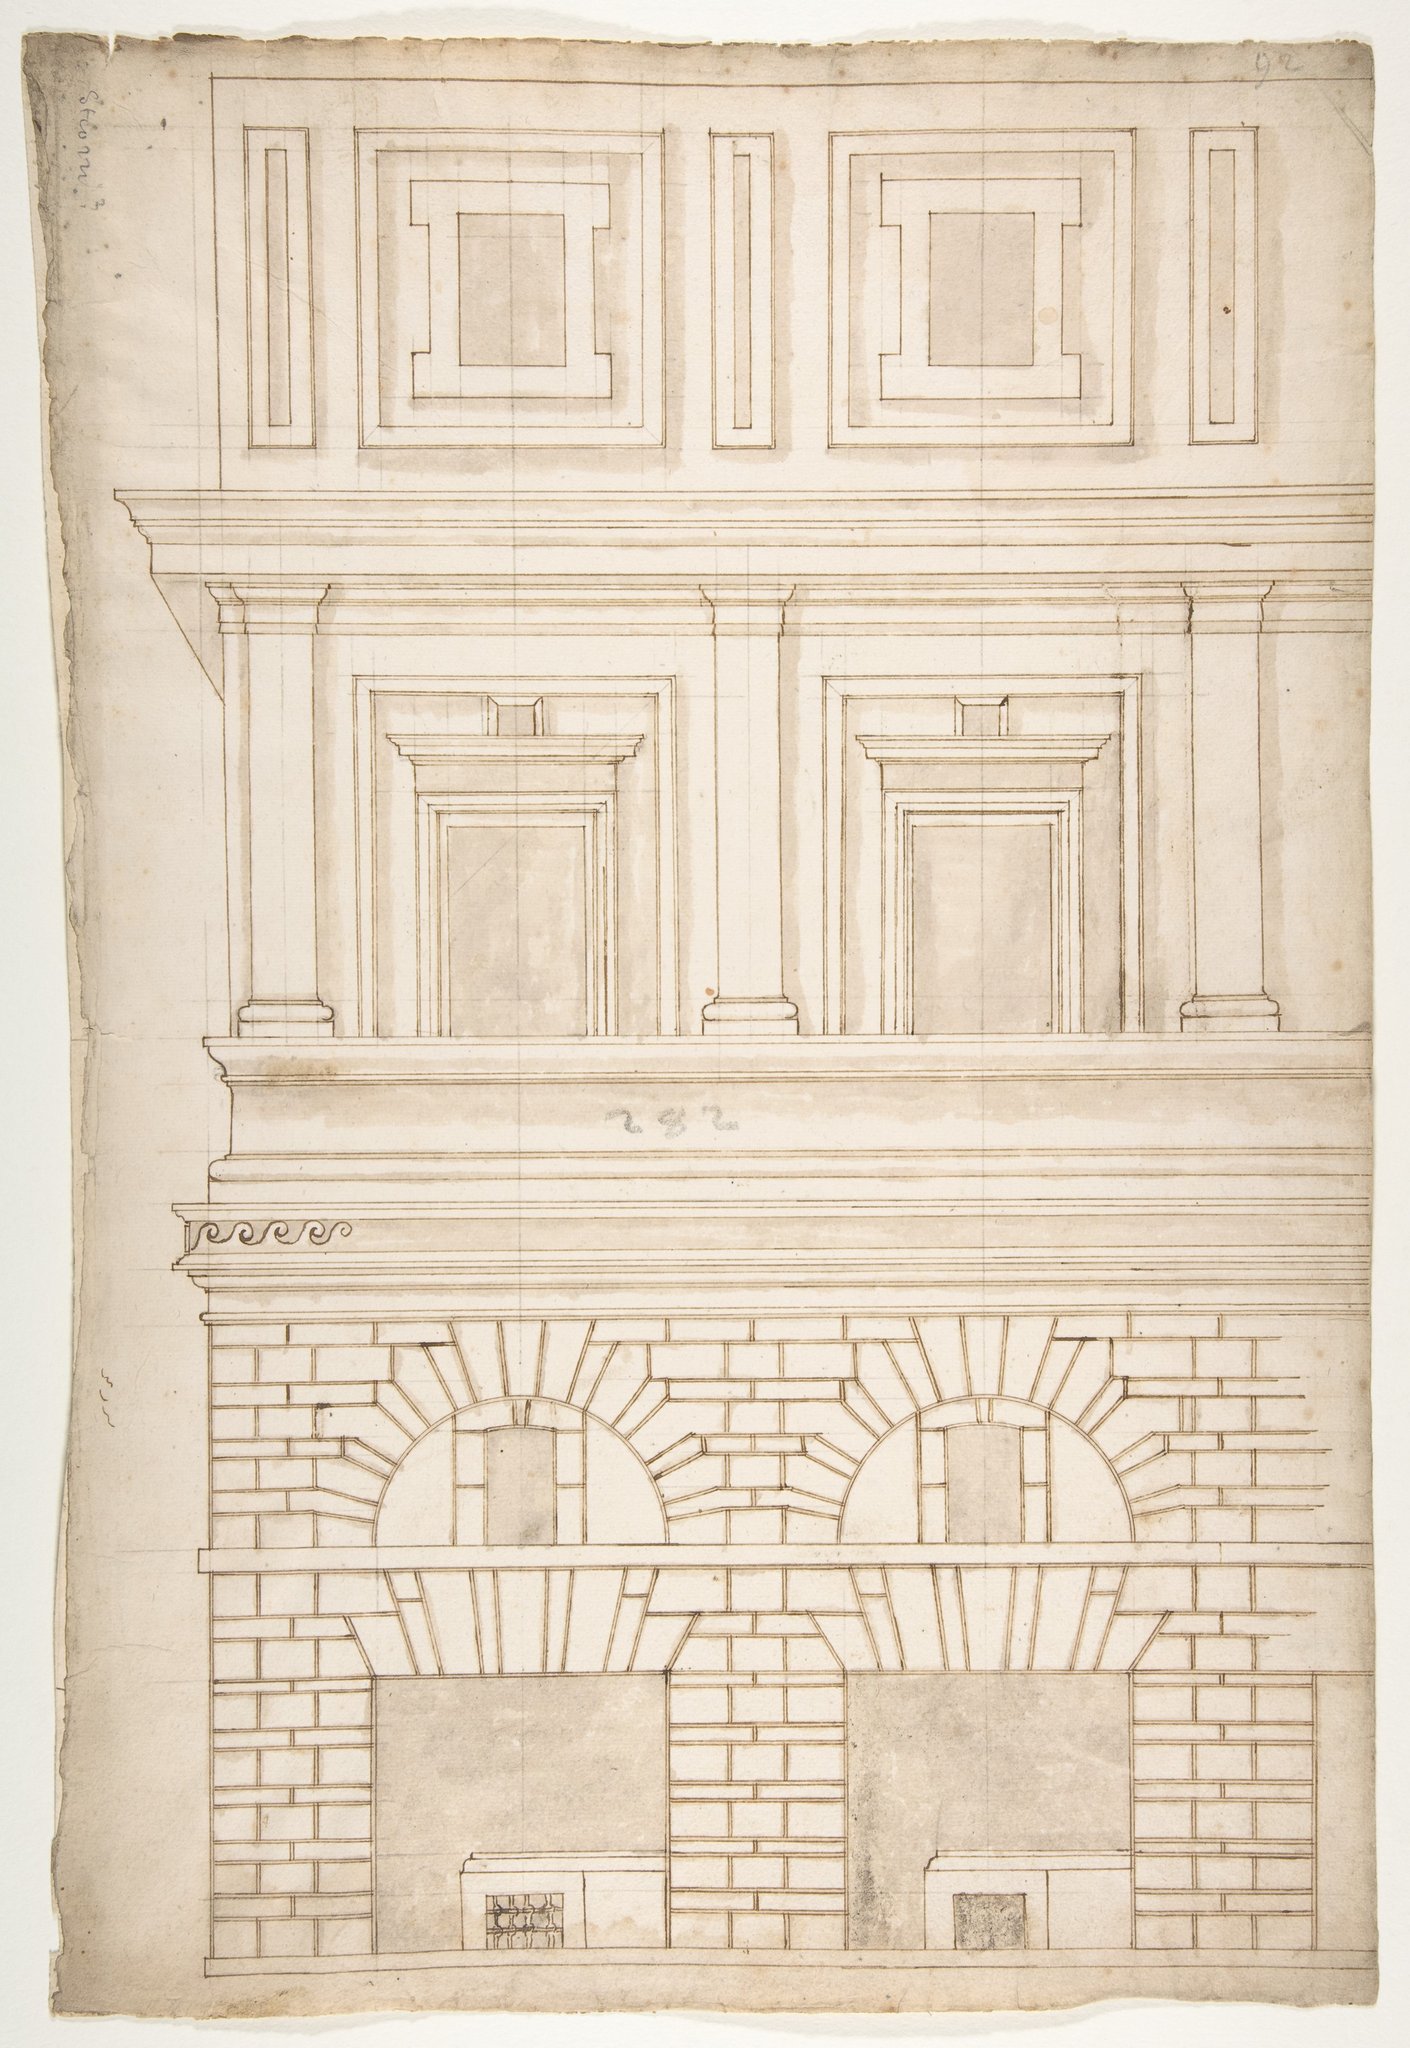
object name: drawing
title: Palazzo Alberini-Cicciaporci, half elevation (recto) blank (verso)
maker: anonymous, french, 16th century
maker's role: draftsman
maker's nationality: french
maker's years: 1500-1600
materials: chalk, ink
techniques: incising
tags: architecture,buildings